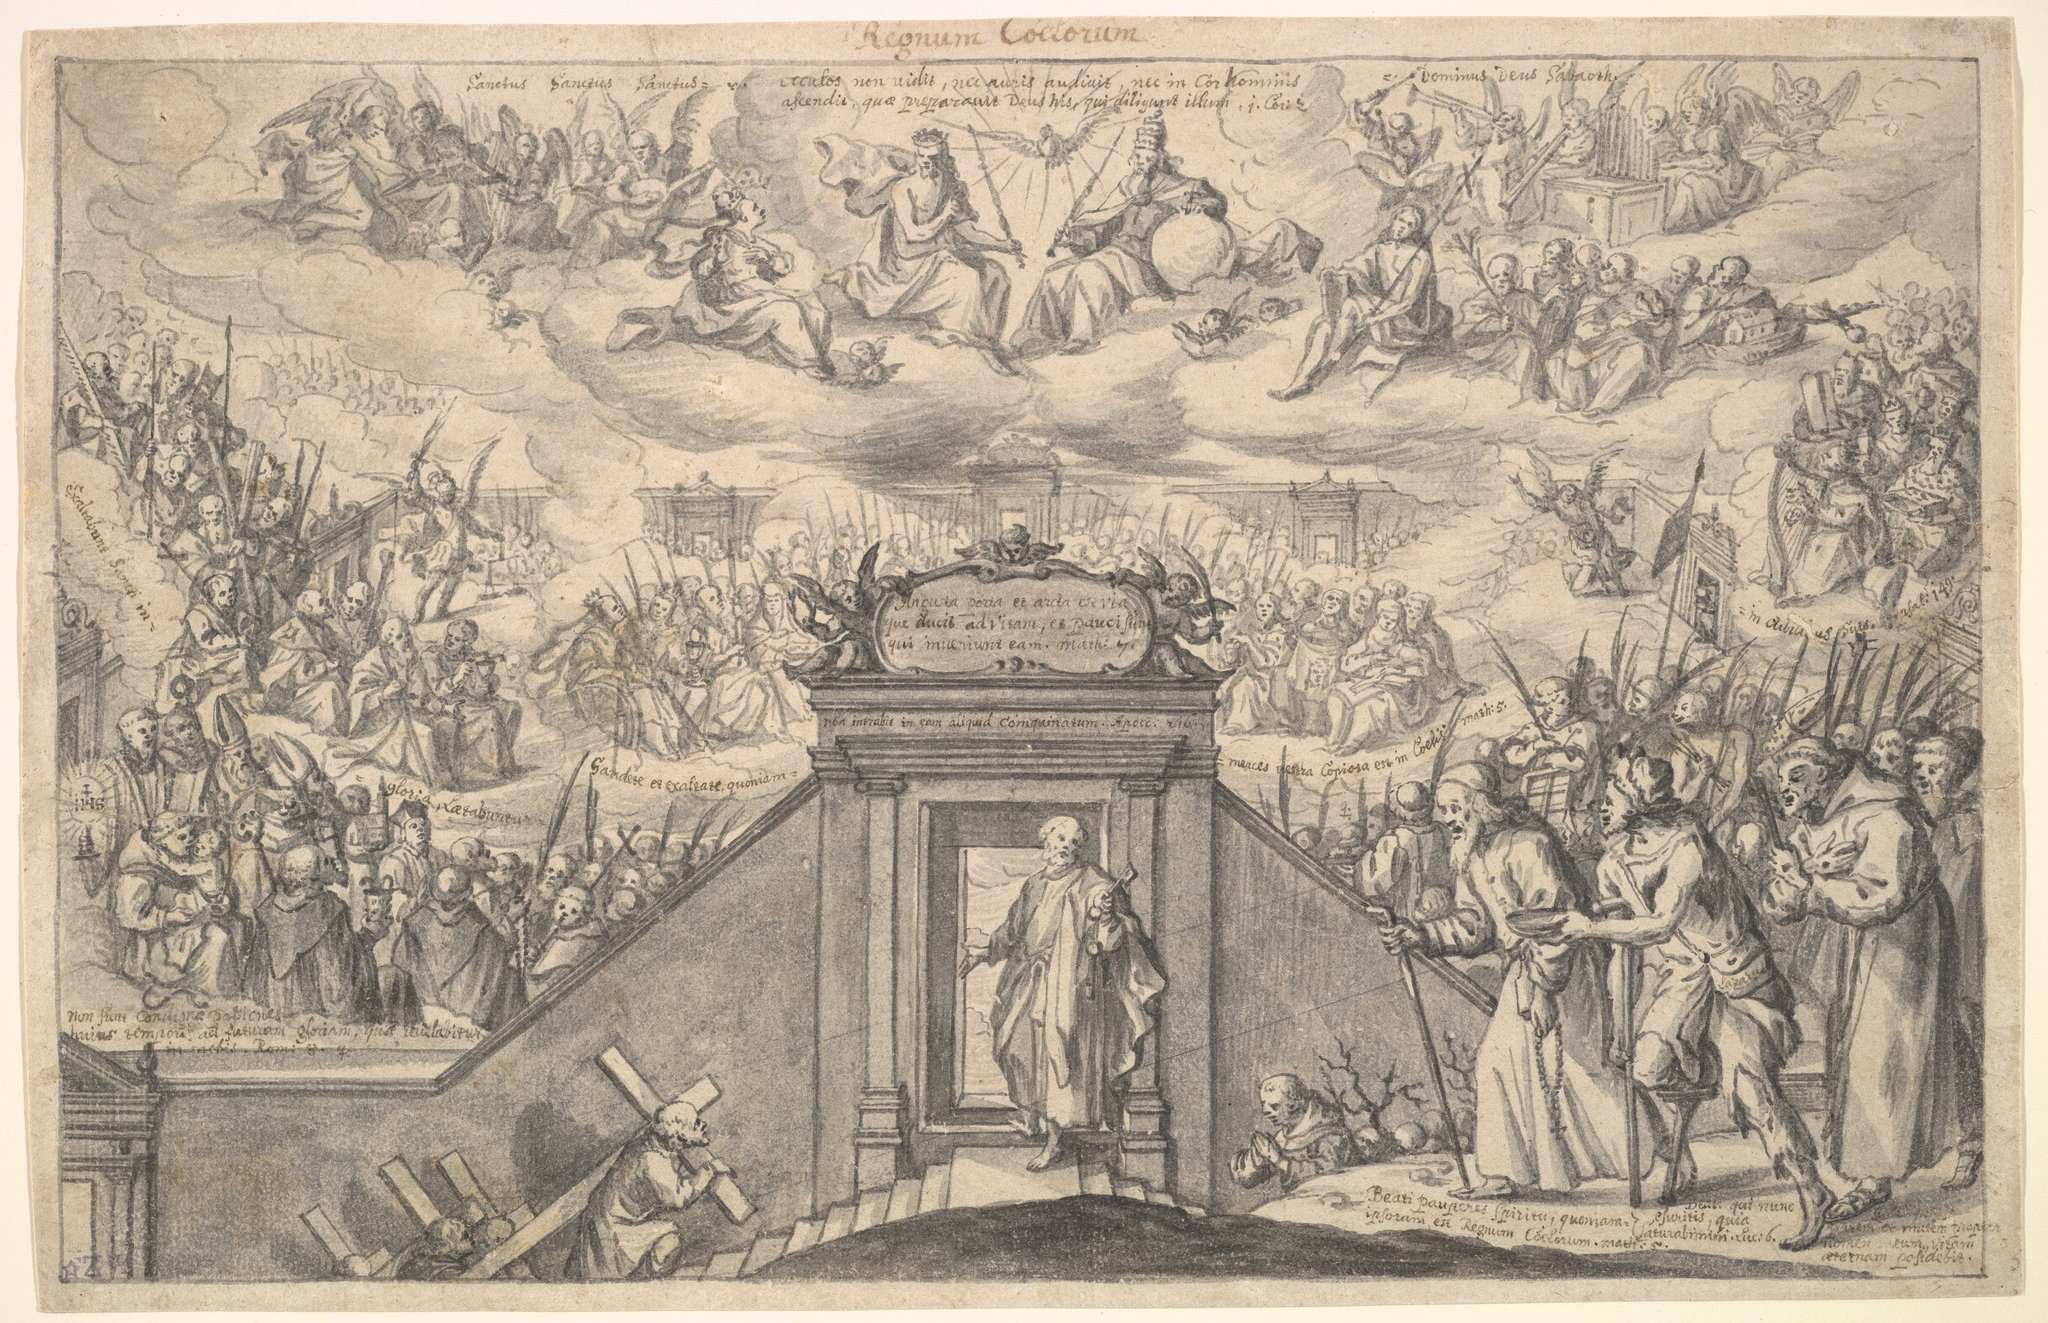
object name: drawing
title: The Reign of Heavens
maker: anonymous, german, 17th century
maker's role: artist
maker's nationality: german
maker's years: 1600-1700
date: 1667-1700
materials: ink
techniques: brush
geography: germany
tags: angels,heaven